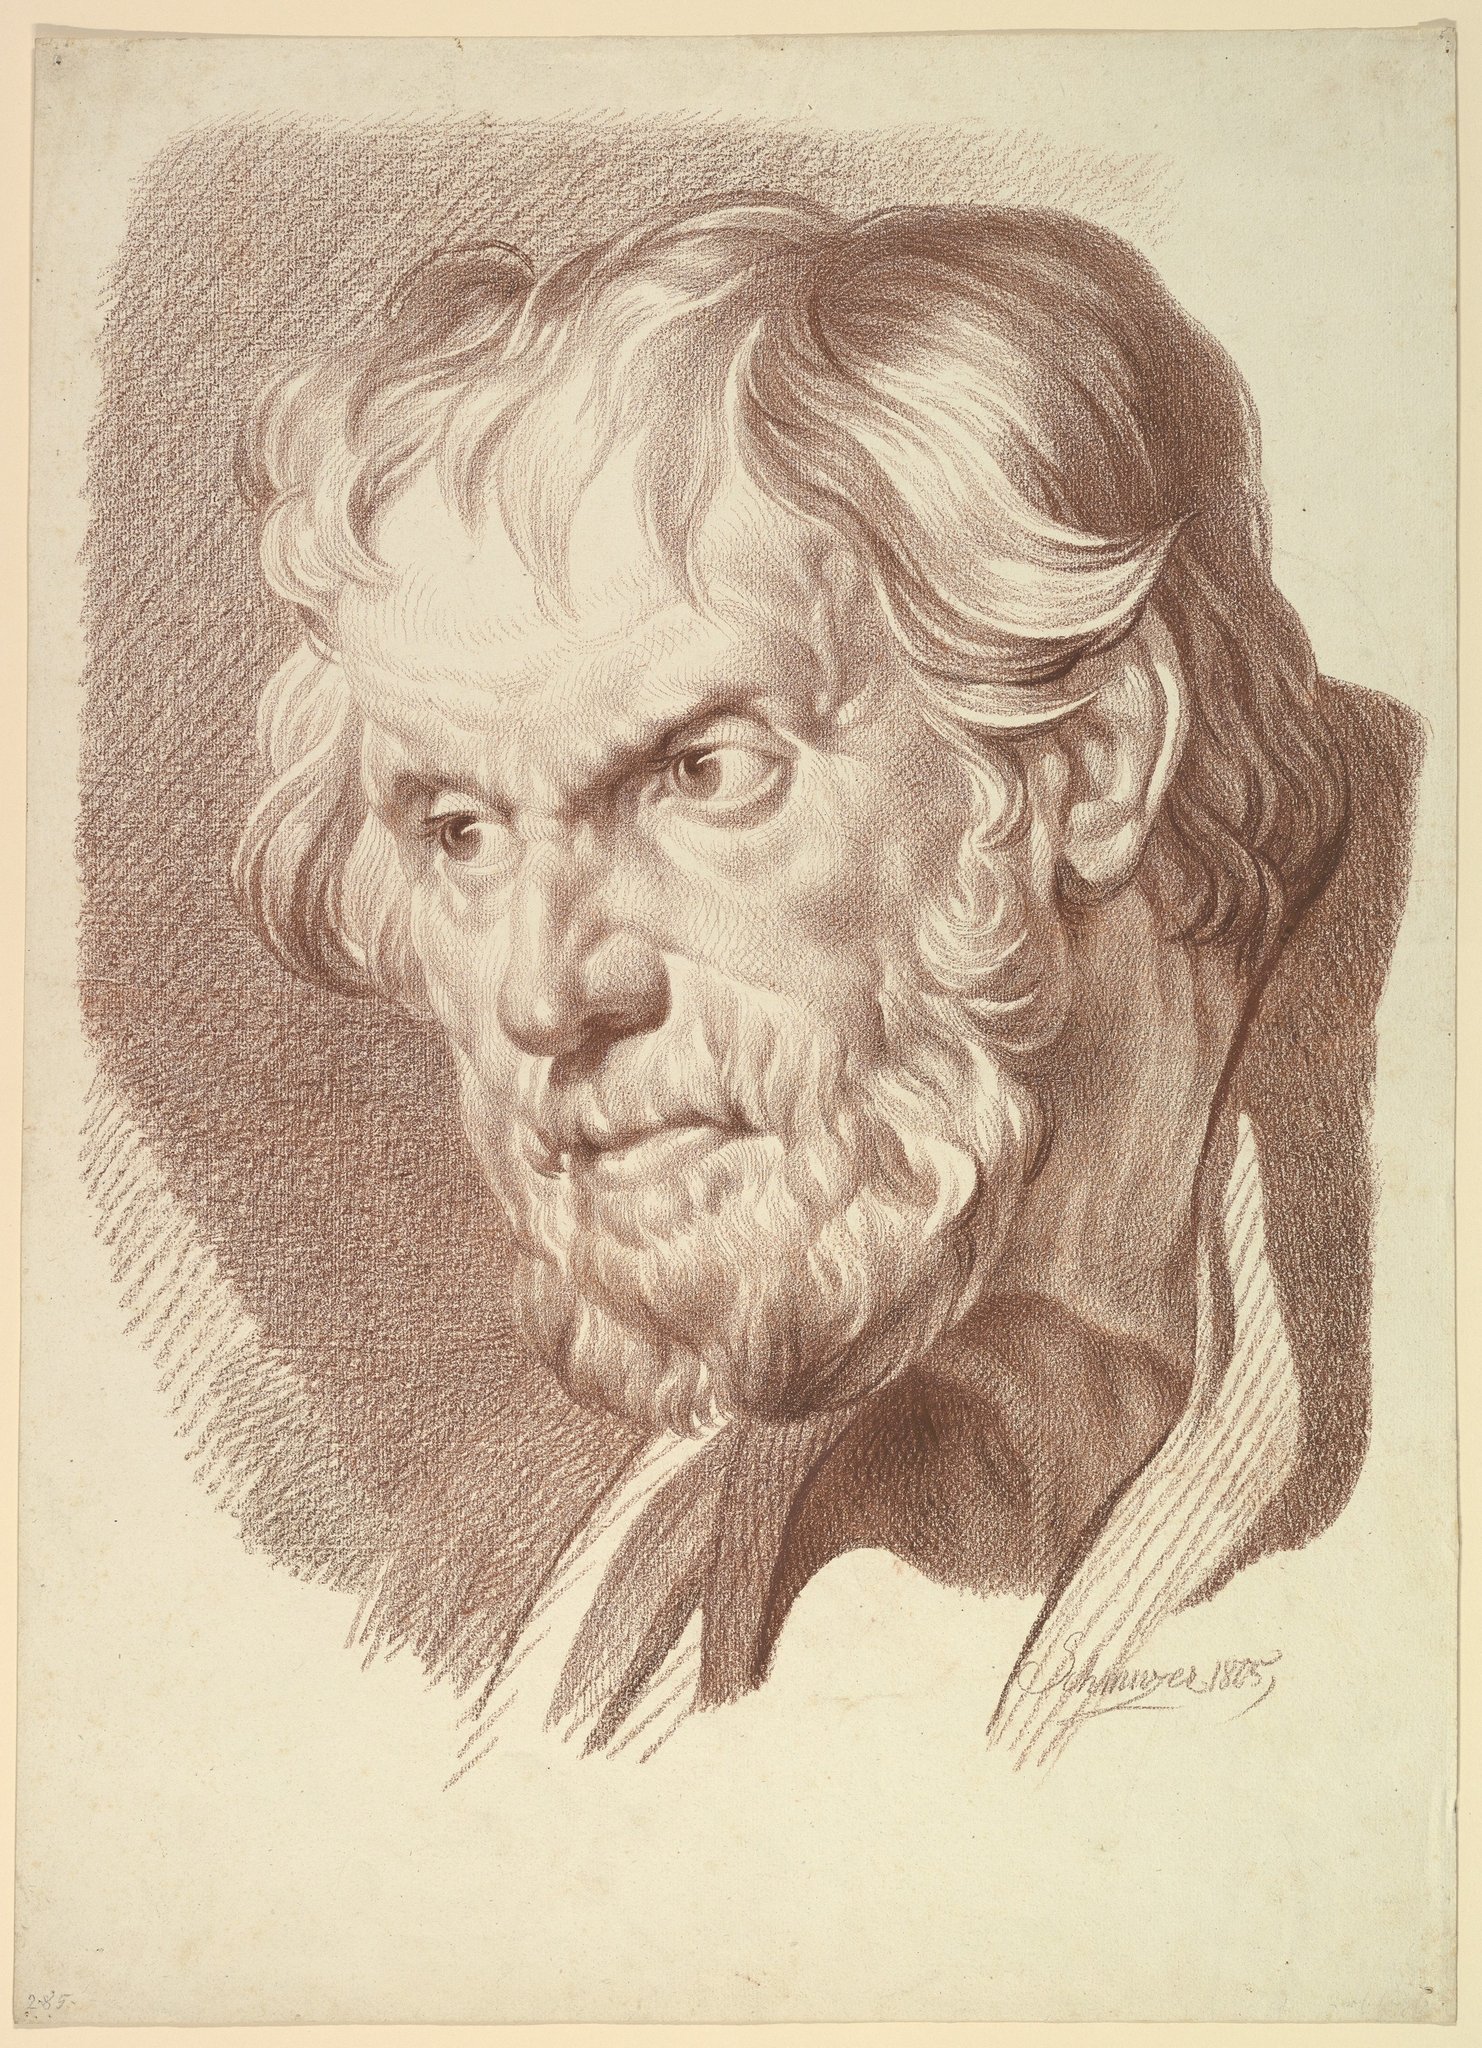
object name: drawing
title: Head of Bearded Old Man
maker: jakob matthias schmutzer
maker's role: artist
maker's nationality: austrian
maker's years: 1733-1811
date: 1805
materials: chalk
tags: heads,men